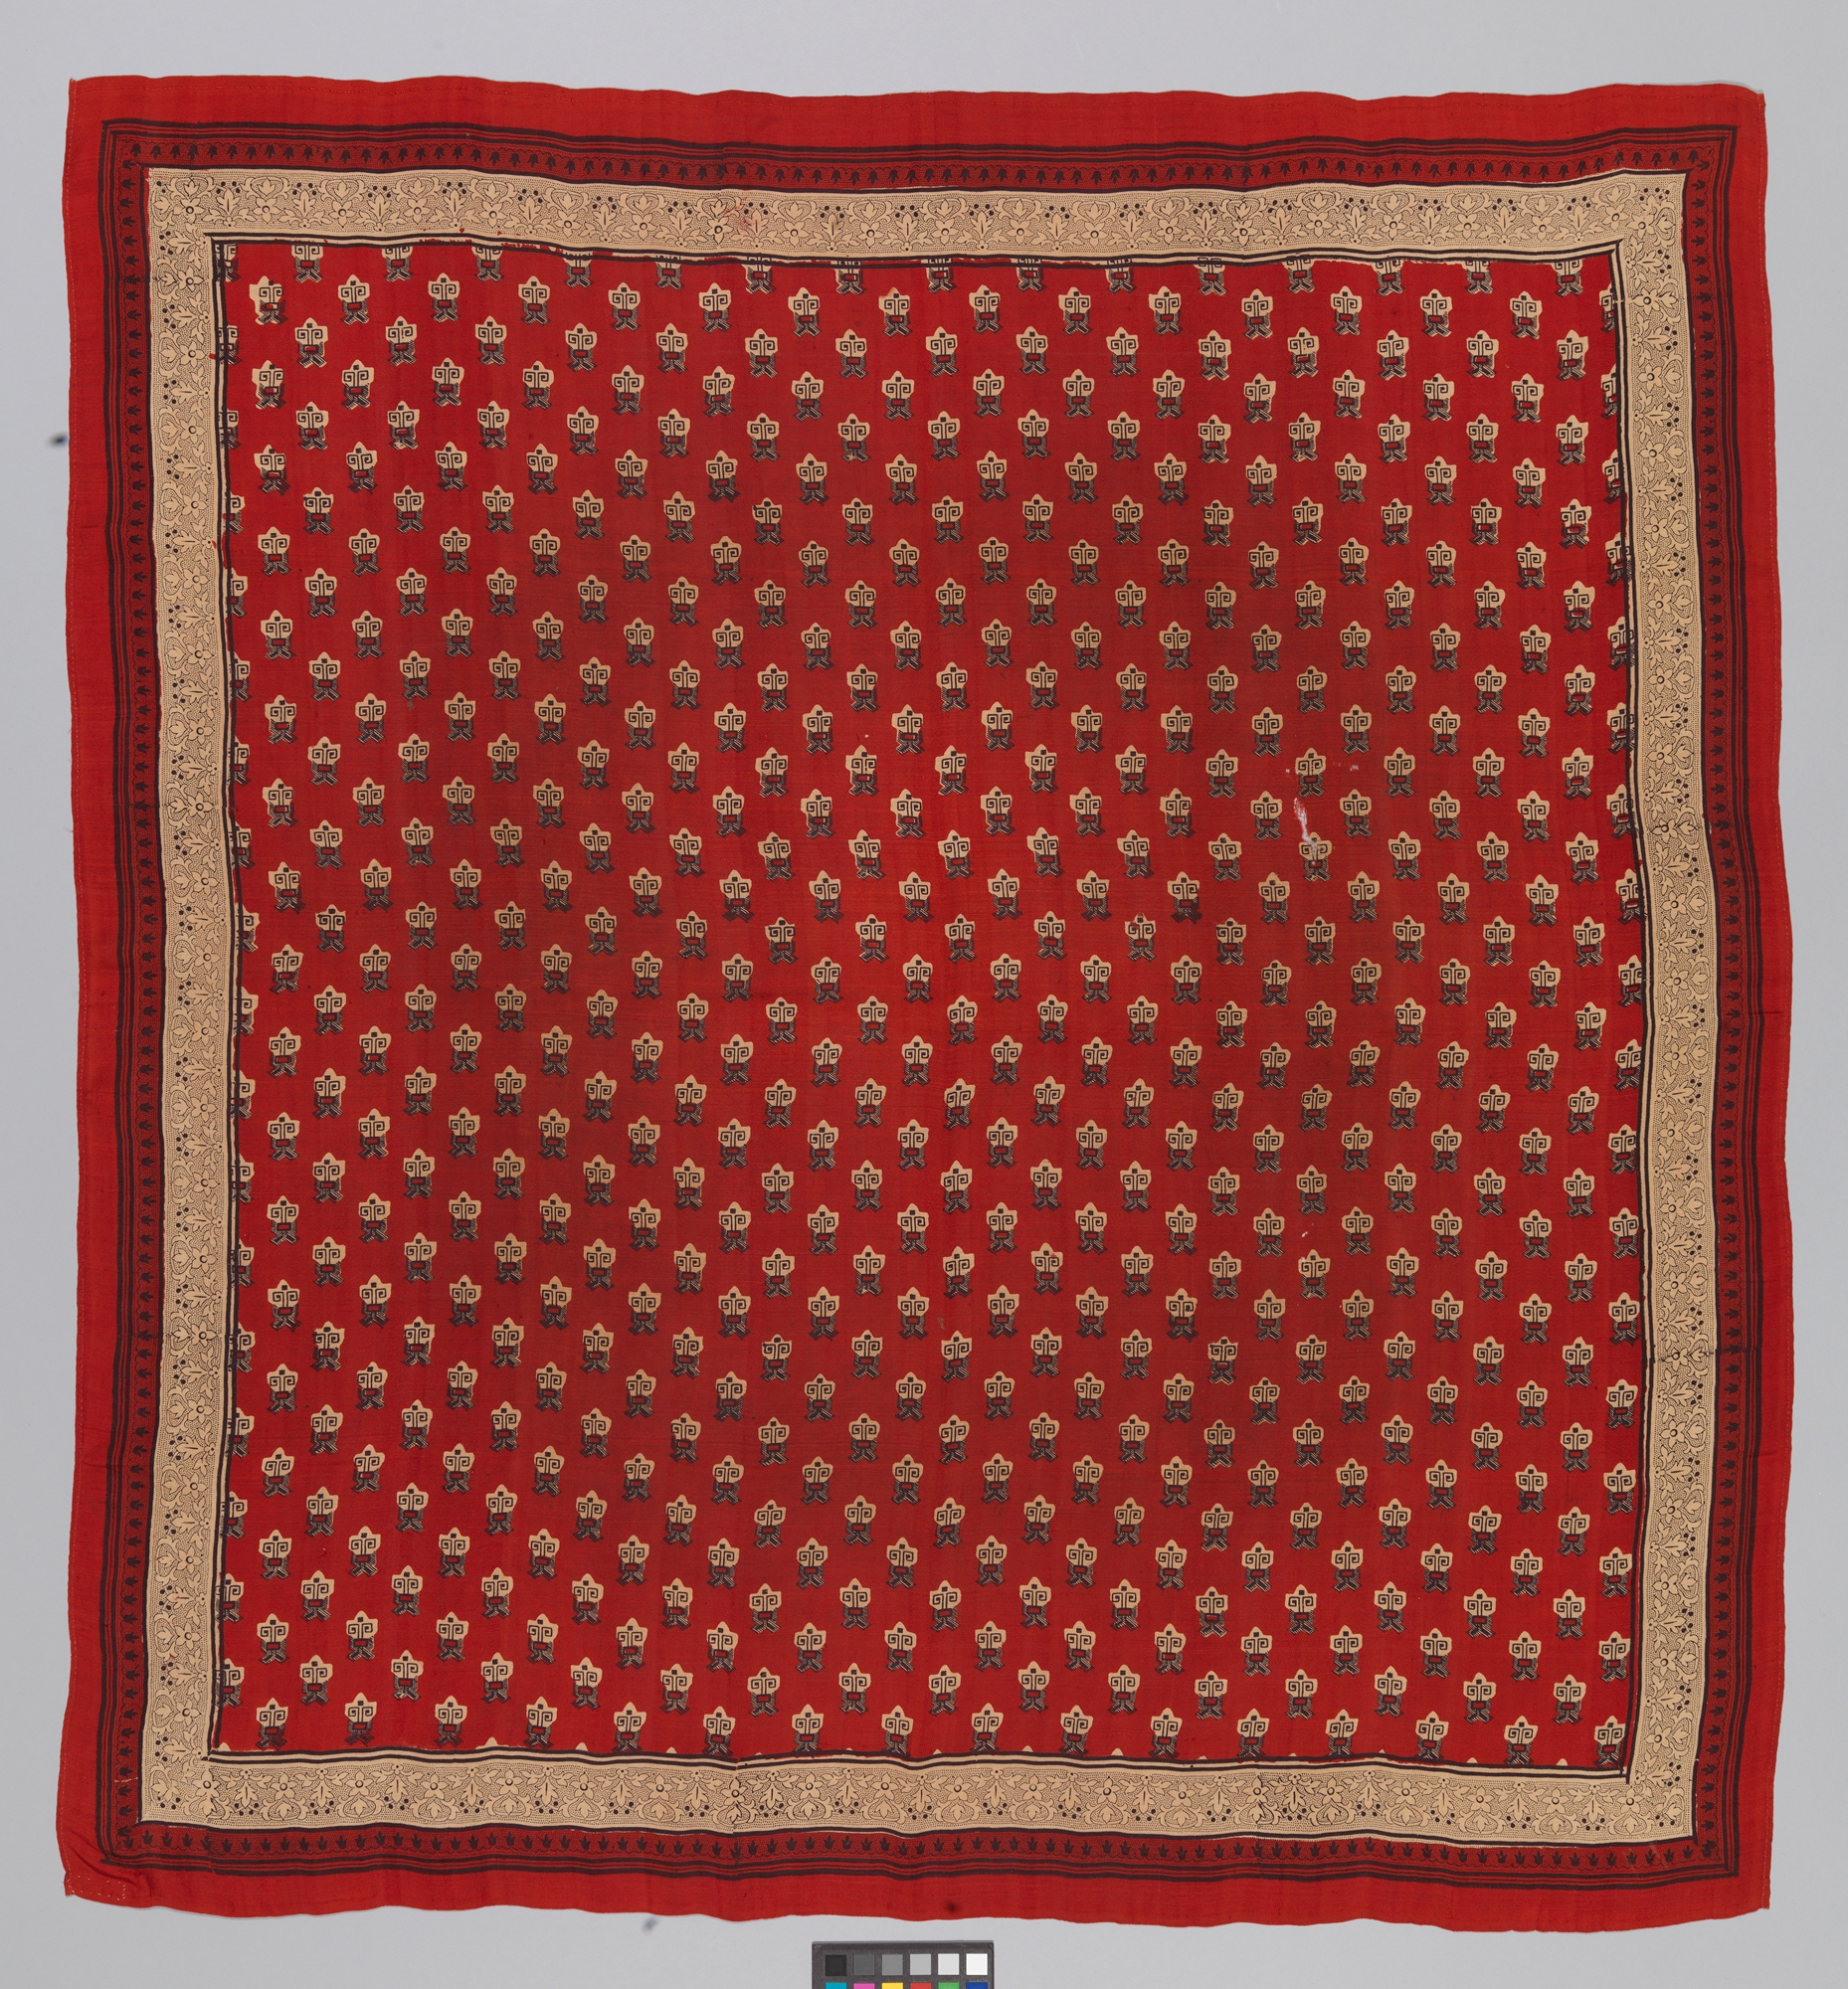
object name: handkerchief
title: Man's handkerchief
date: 1801-1900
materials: silk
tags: flowers